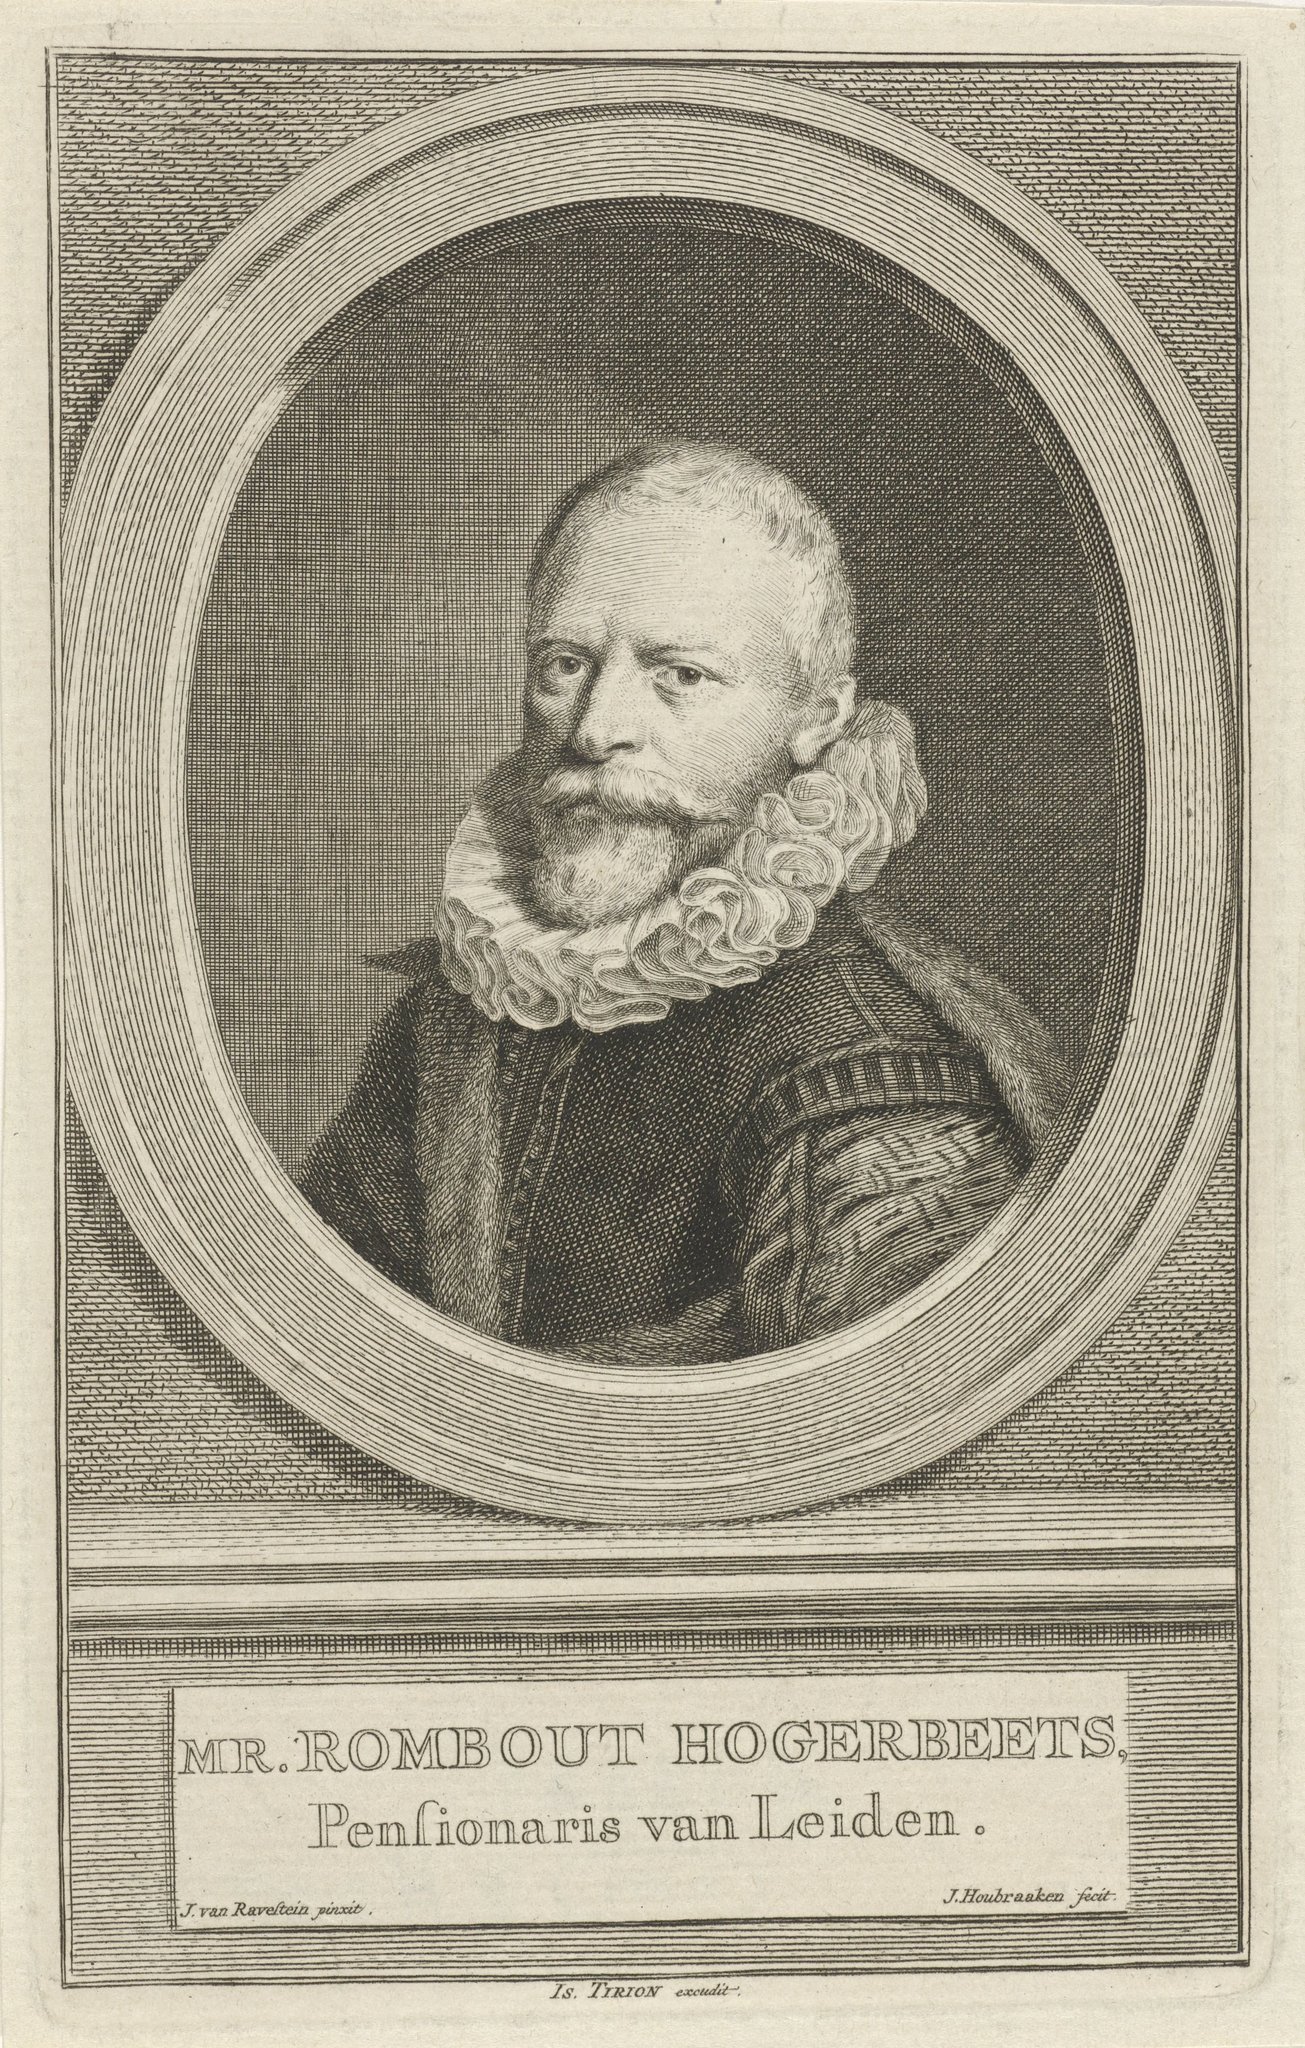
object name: print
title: Mr. Rombout Hogerbeets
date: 1749-1759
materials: paper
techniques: engraving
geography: amsterdam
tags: hoorn (north holland)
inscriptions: collector's mark: Lugt 2228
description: Prent ook gebruikt in: Jan Wagenaar, Vaderlandsche historie, vervattende de geschiedenissen der nu Vereenigde Nederlanden, inzonderheid die van Holland (...), 21 delen. Amsterdam, Isaak Tirion, 1749-59.